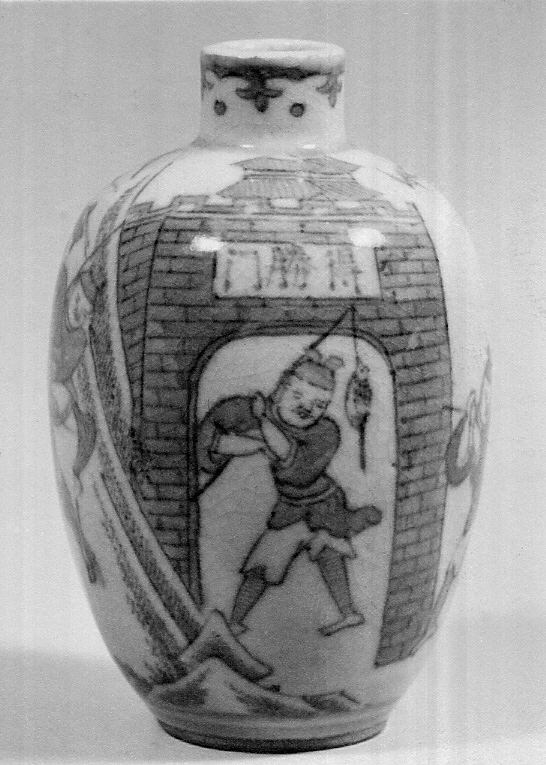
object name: snuff bottle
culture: chinese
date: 1736-1795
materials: paste, porcelain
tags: men